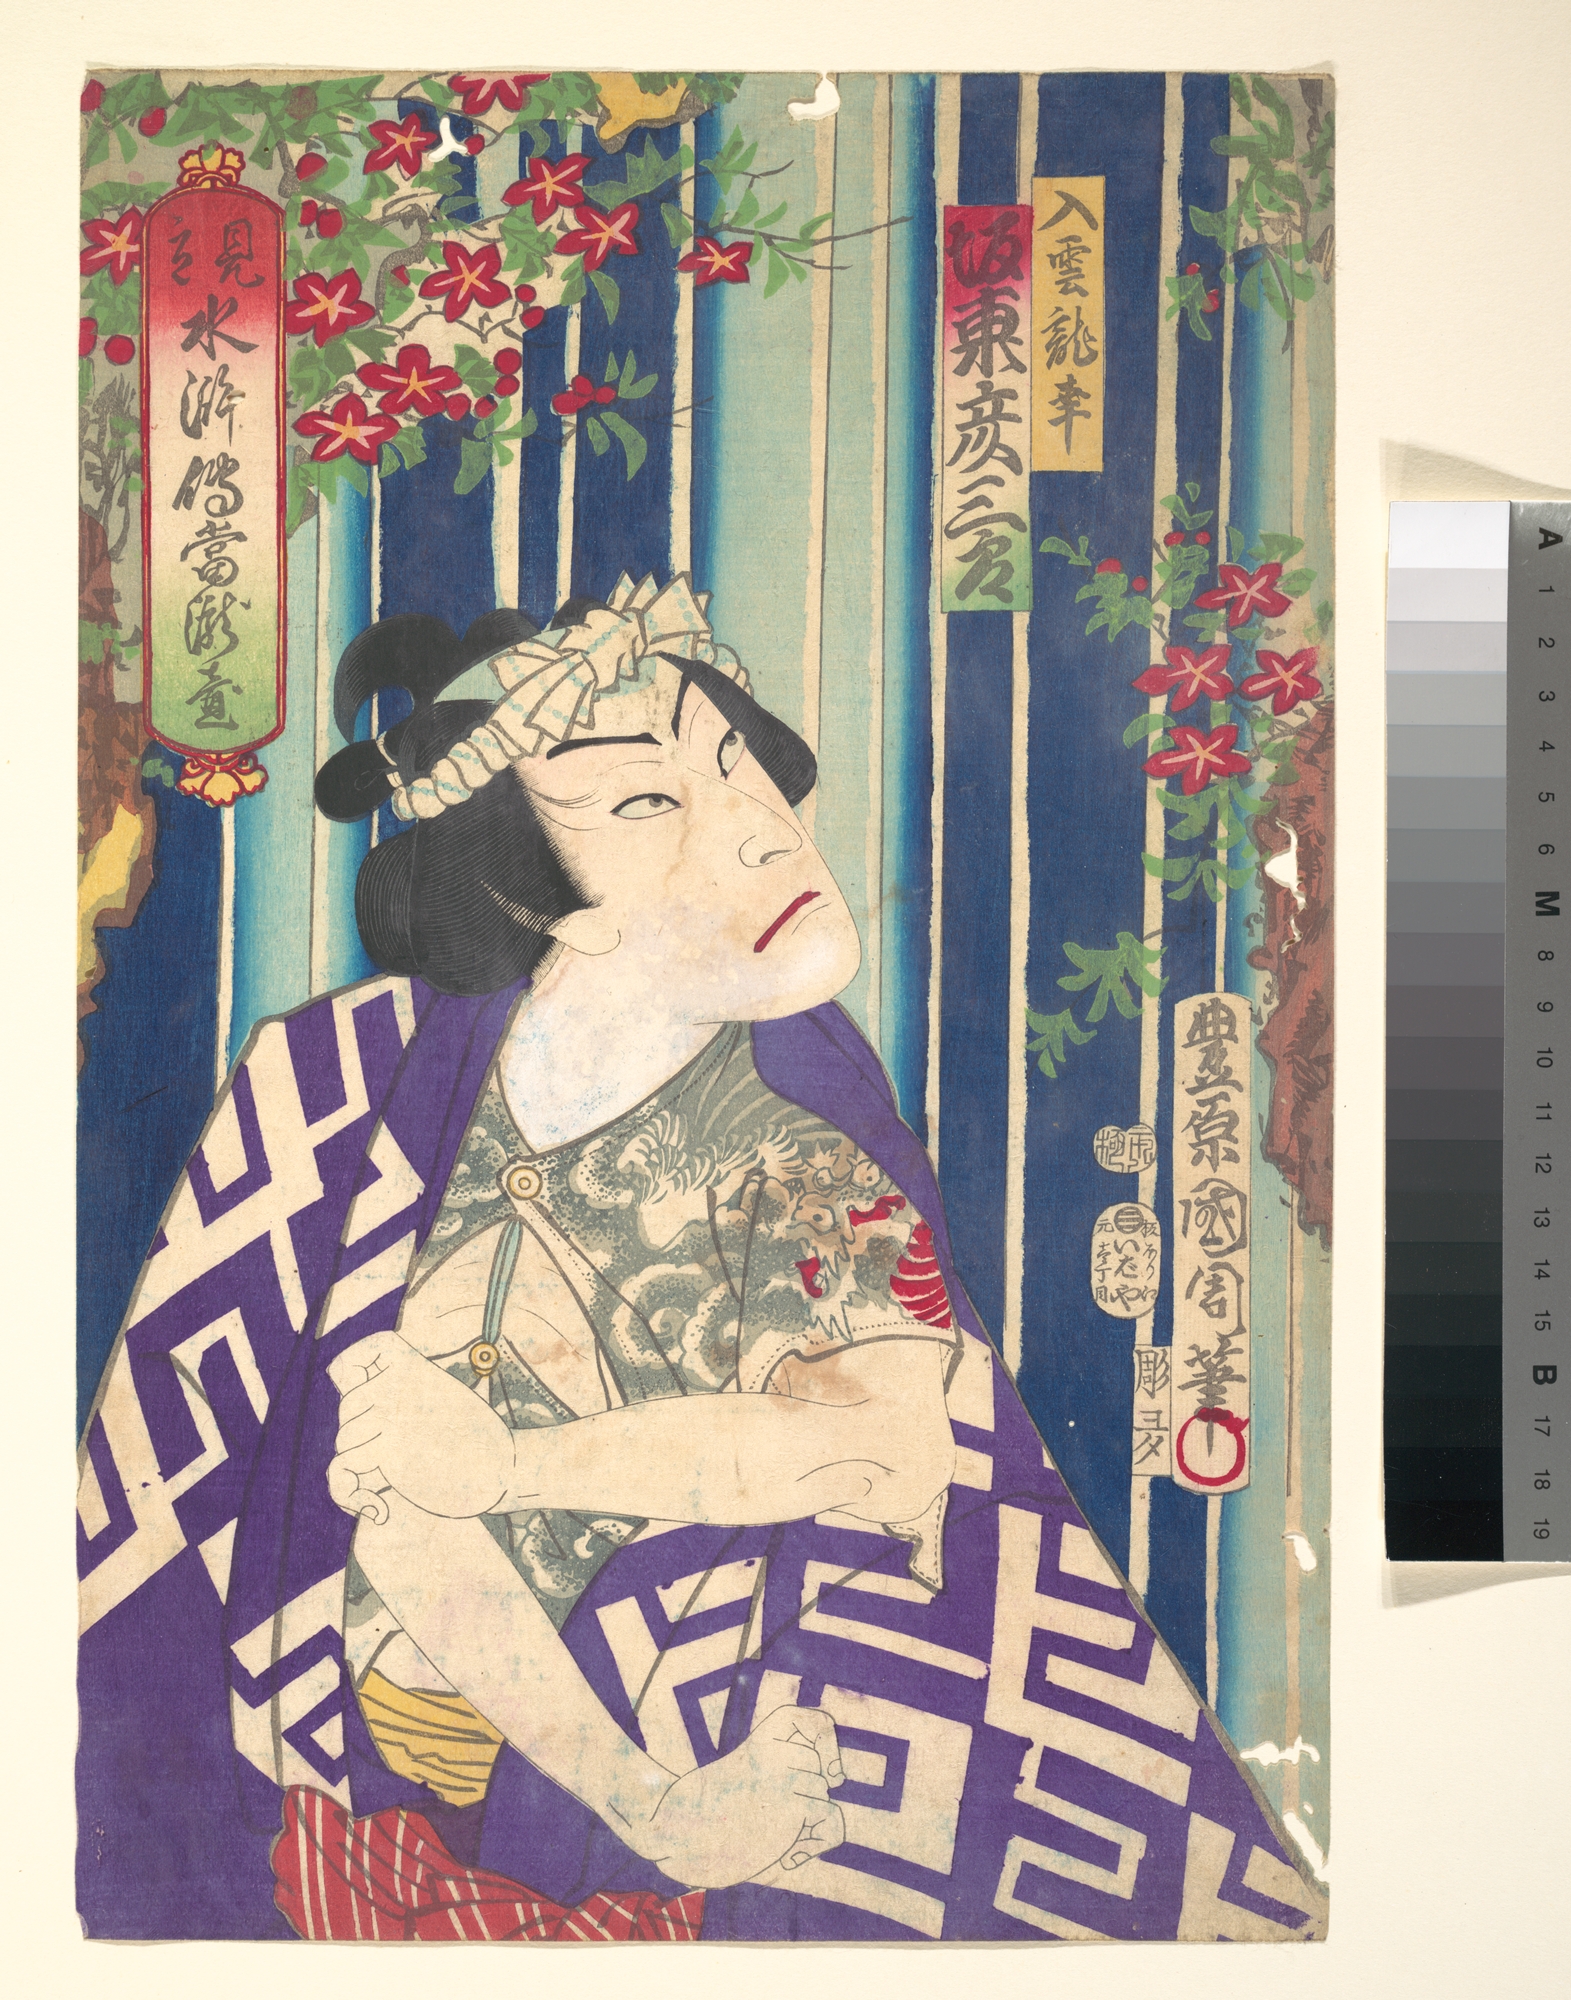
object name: print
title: Imaginary portrait, Shuihuzhuan of Stage: Tōryūdai (Mitate Suikoden Tōrōdai) - Actor, Bandō Hikozaburō plays as Nyūunryū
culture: japanese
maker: toyohara kunichika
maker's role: artist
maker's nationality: japanese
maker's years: 1835-1900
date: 1875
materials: ink, paper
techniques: woodblock print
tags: men,actors